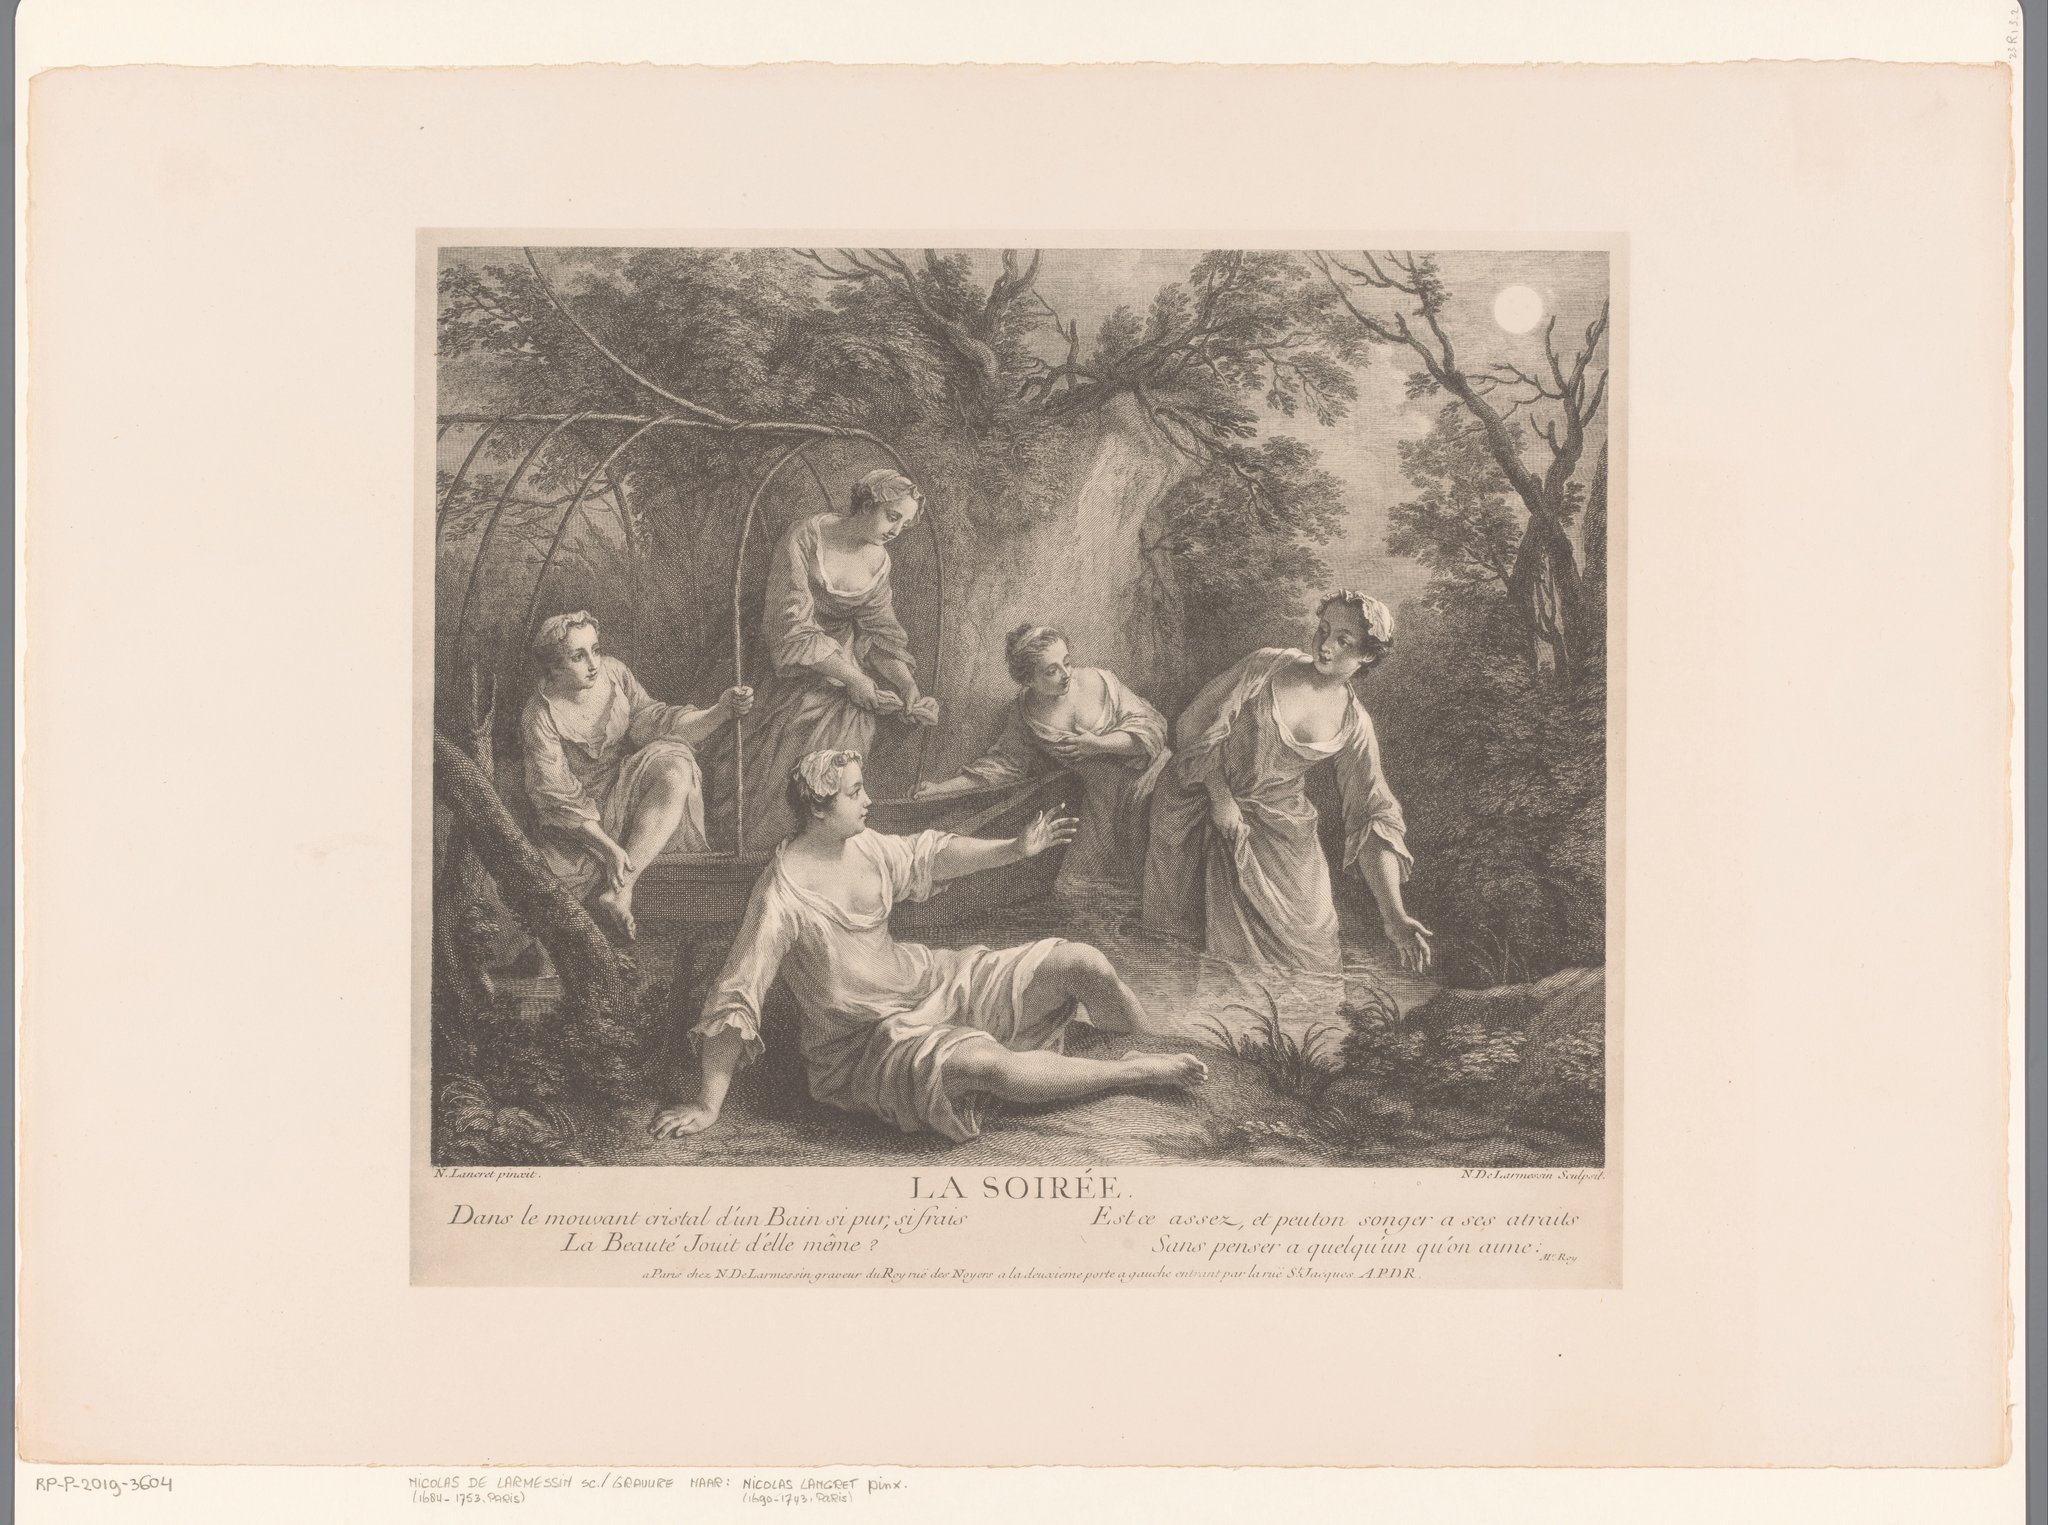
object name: photomechanical print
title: Vier dagdelen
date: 1912-1961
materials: paper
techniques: photograph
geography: amsterdam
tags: full moon, evening, public baths - aa - in the open air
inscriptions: collector's mark: Lugt 2228, annotation: ‘uitgave Gebr. Graauw/ Singel Amsterdam’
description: Maakt deel uit van vierdelige serie met de vier dagdelen.